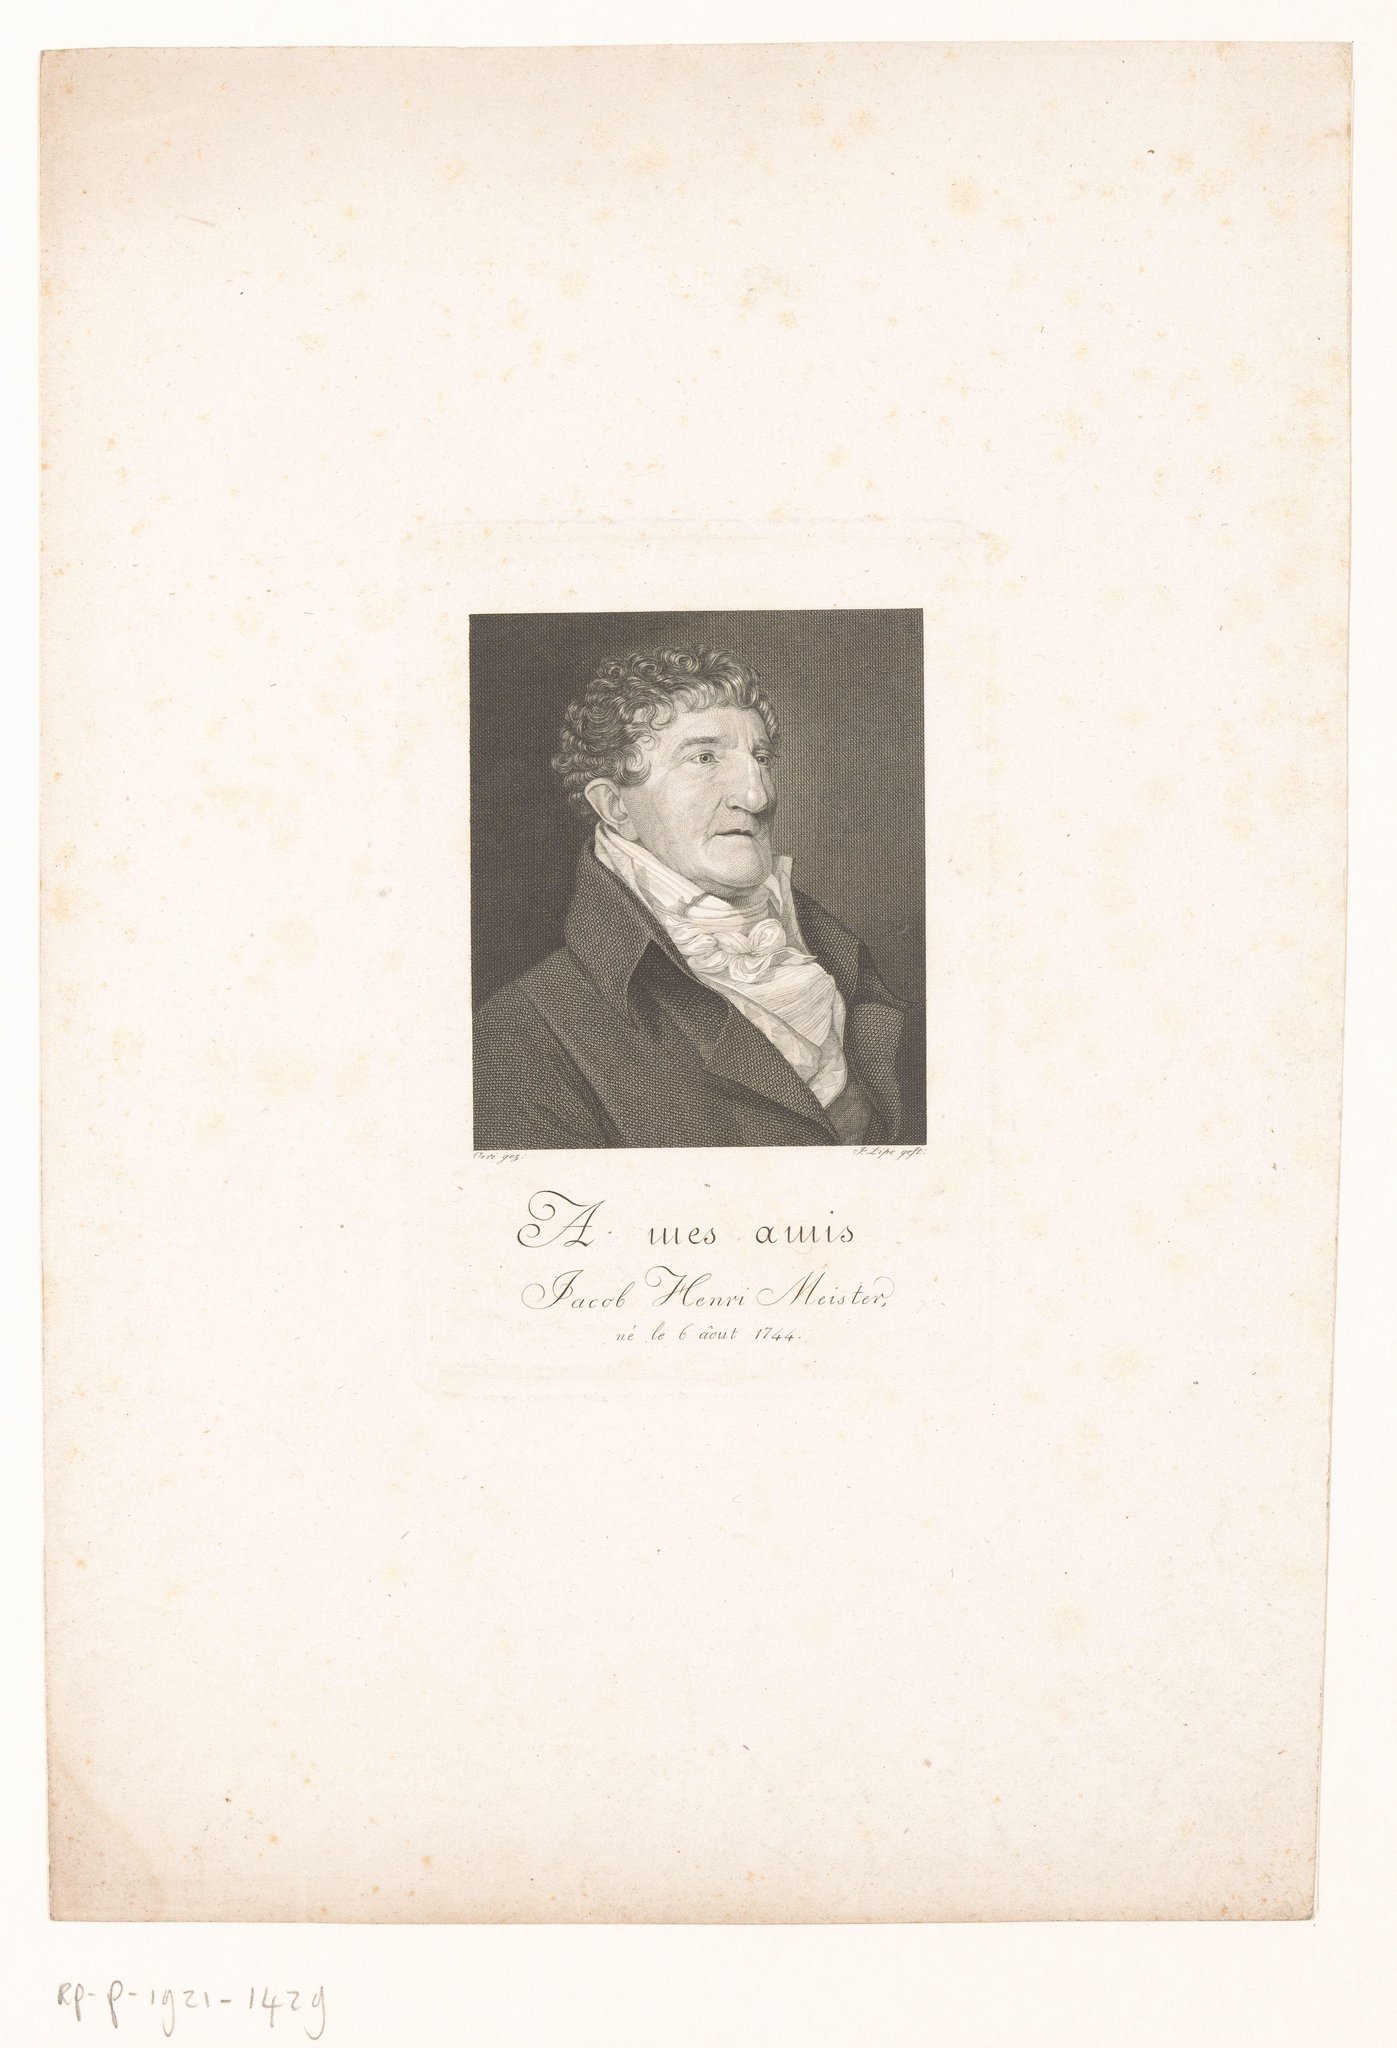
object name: print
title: Portret van Jacob Henri Meister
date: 1801-1833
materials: paper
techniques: engraving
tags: historical persons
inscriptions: collector's mark: Lugt 2228